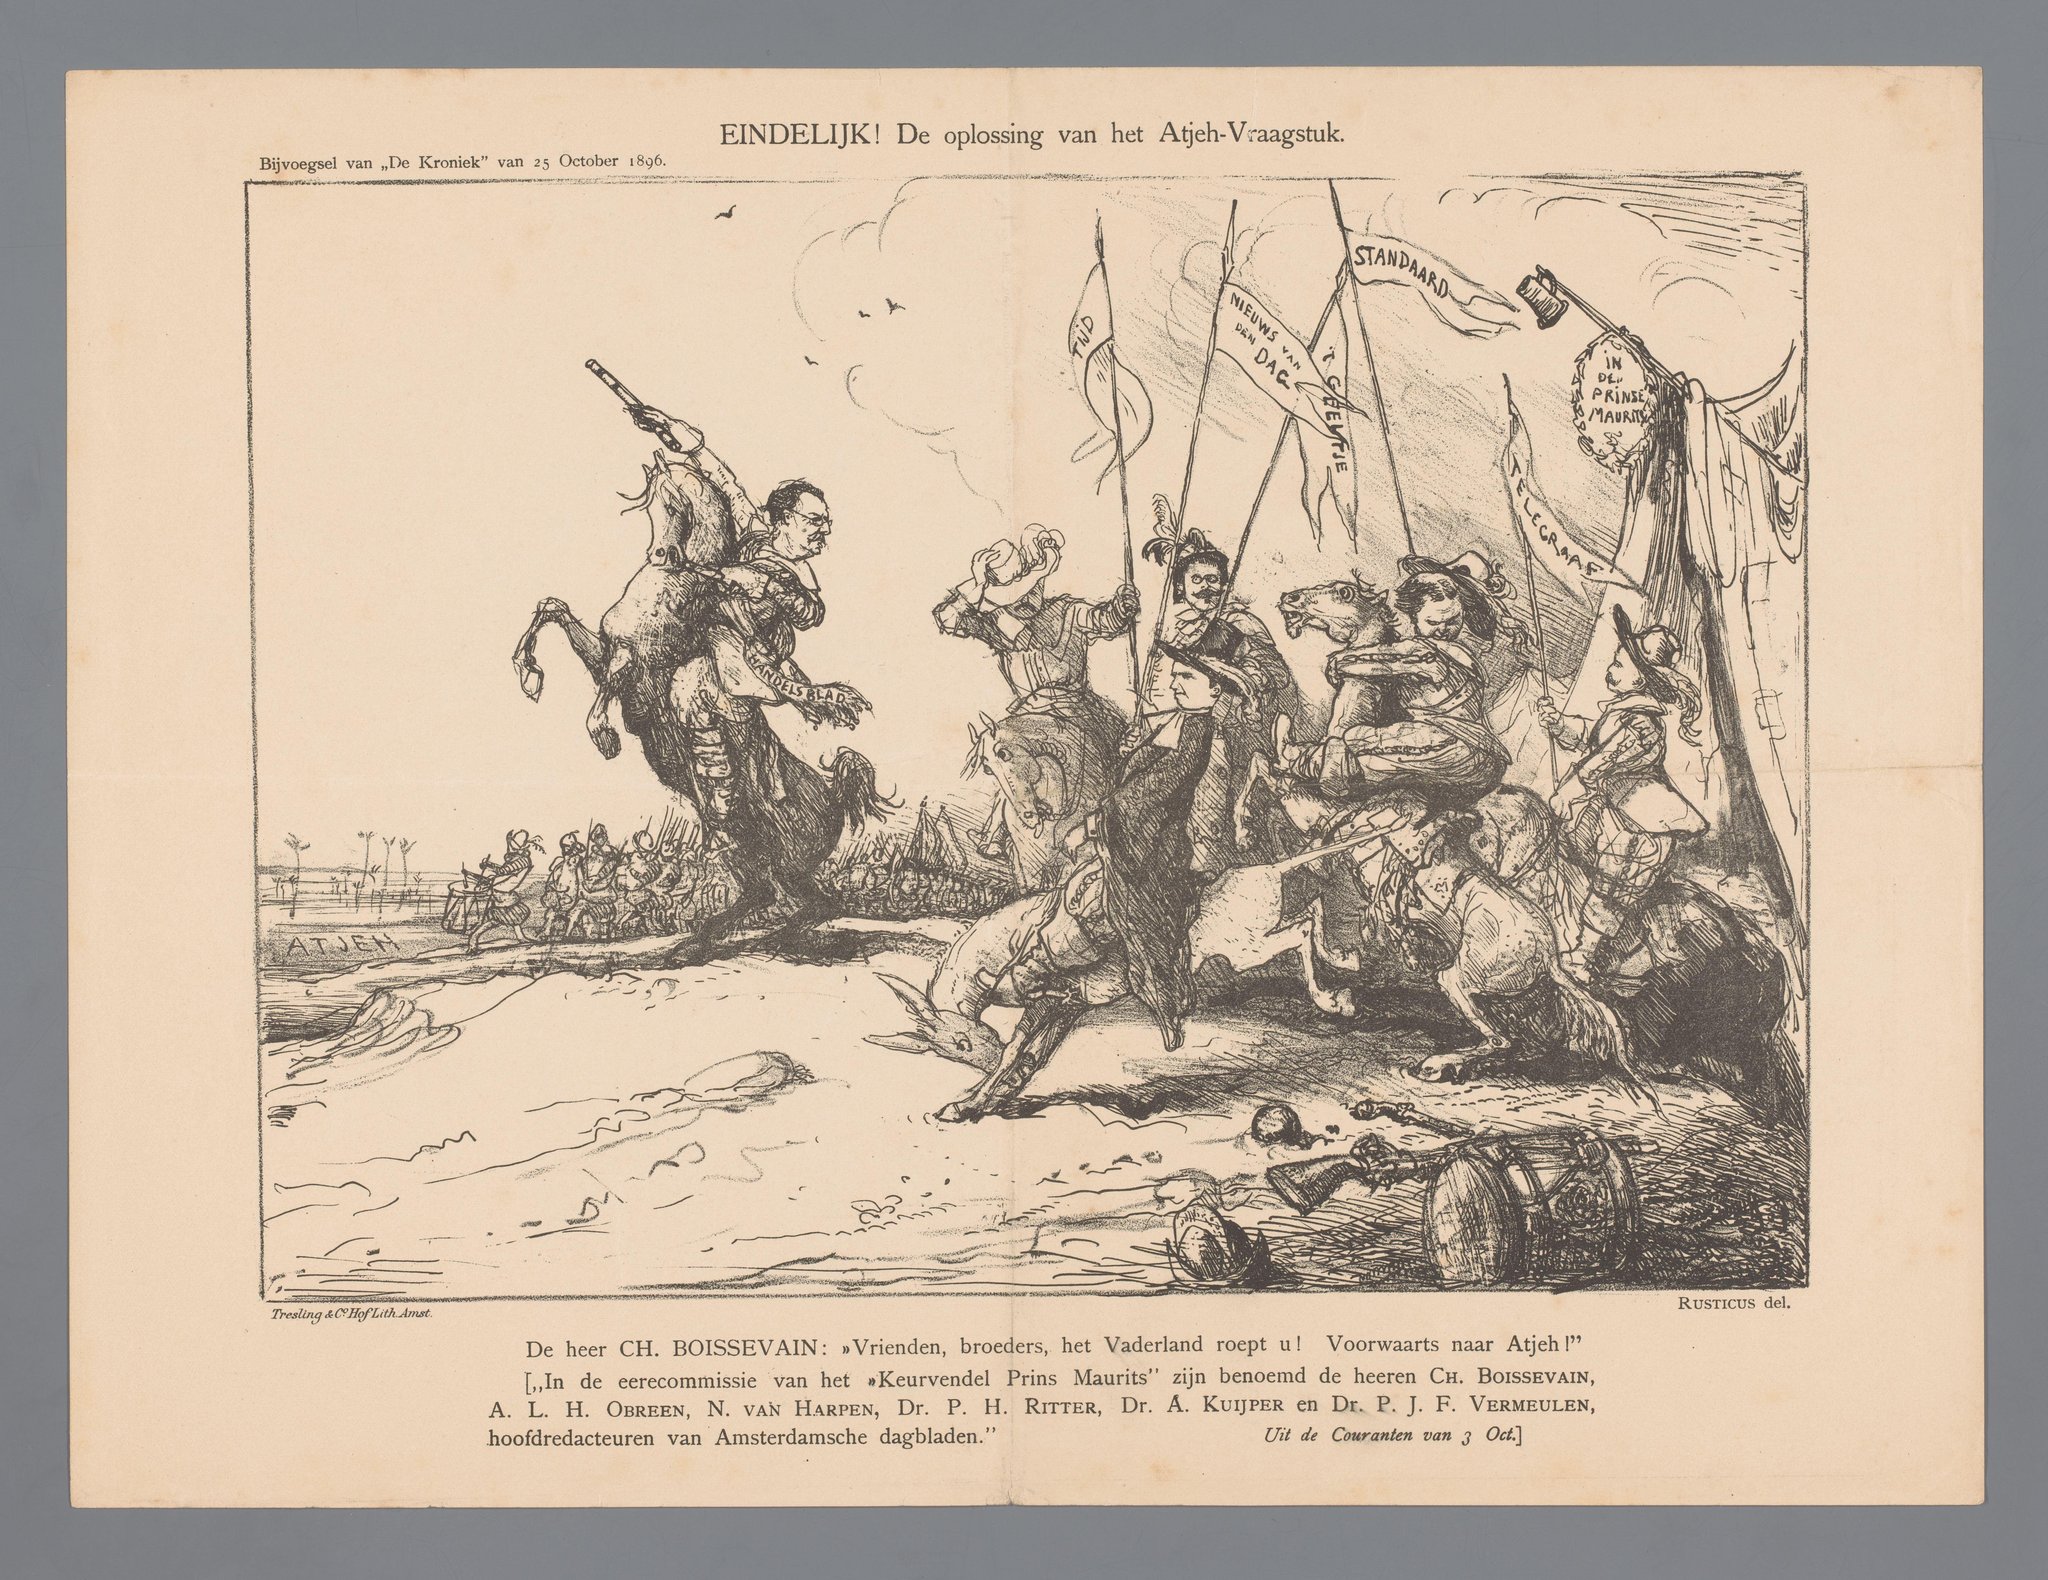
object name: cartoon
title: Eindelijk! De oplossing van het Atjeh-Vraagstuk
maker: marius bauer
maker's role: draughtsman, print maker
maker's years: 1867-1932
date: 1896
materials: paper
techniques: lithograph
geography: amsterdam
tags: charles boissevain, horse, fighting, political caricatures and satires, netherlands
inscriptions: date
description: Spotprent op Amsterdamse dagbladen die gemakkelijk oplossingen bepleiten voor het Atjeh-vraagstuk. Boissevain, hoofdredacteur van het Algemeen Handelsblad, roept de anderen op hem naar Atjeh te volgen, maar die weigeren. Verschenen in de bijvoegsel van 'De Kroniek' van 25 oktober 1896.